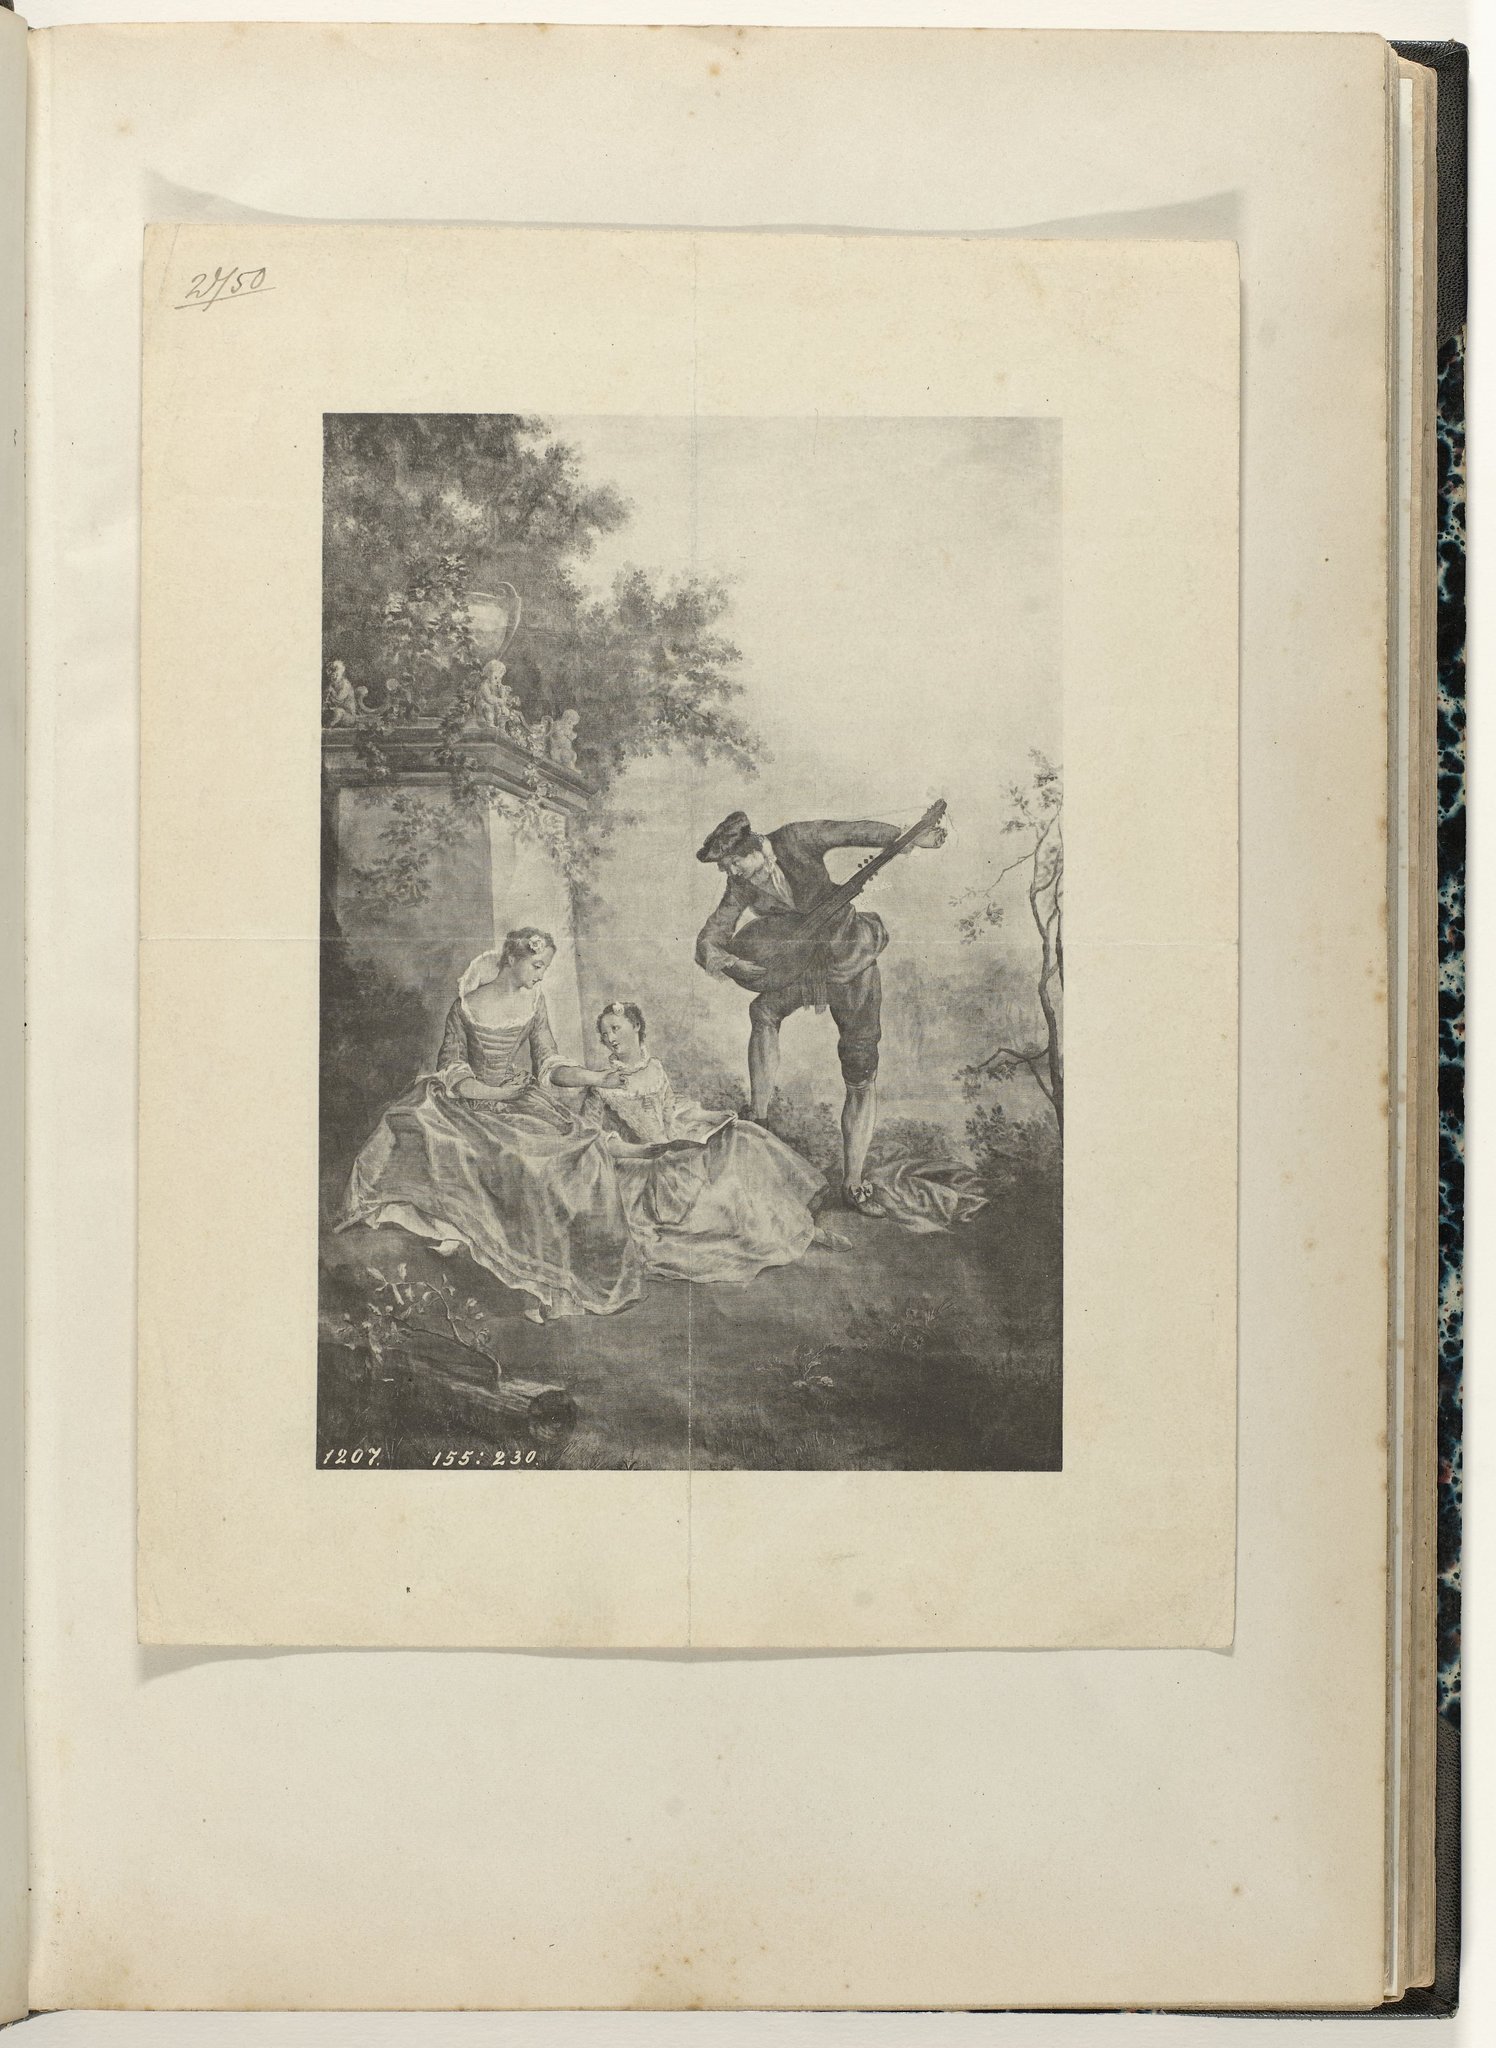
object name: photograph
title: Twee zittende vrouwen en een man spelend op een luit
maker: Anonymous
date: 1866-1900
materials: paper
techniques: printing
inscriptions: number: ‘2750’